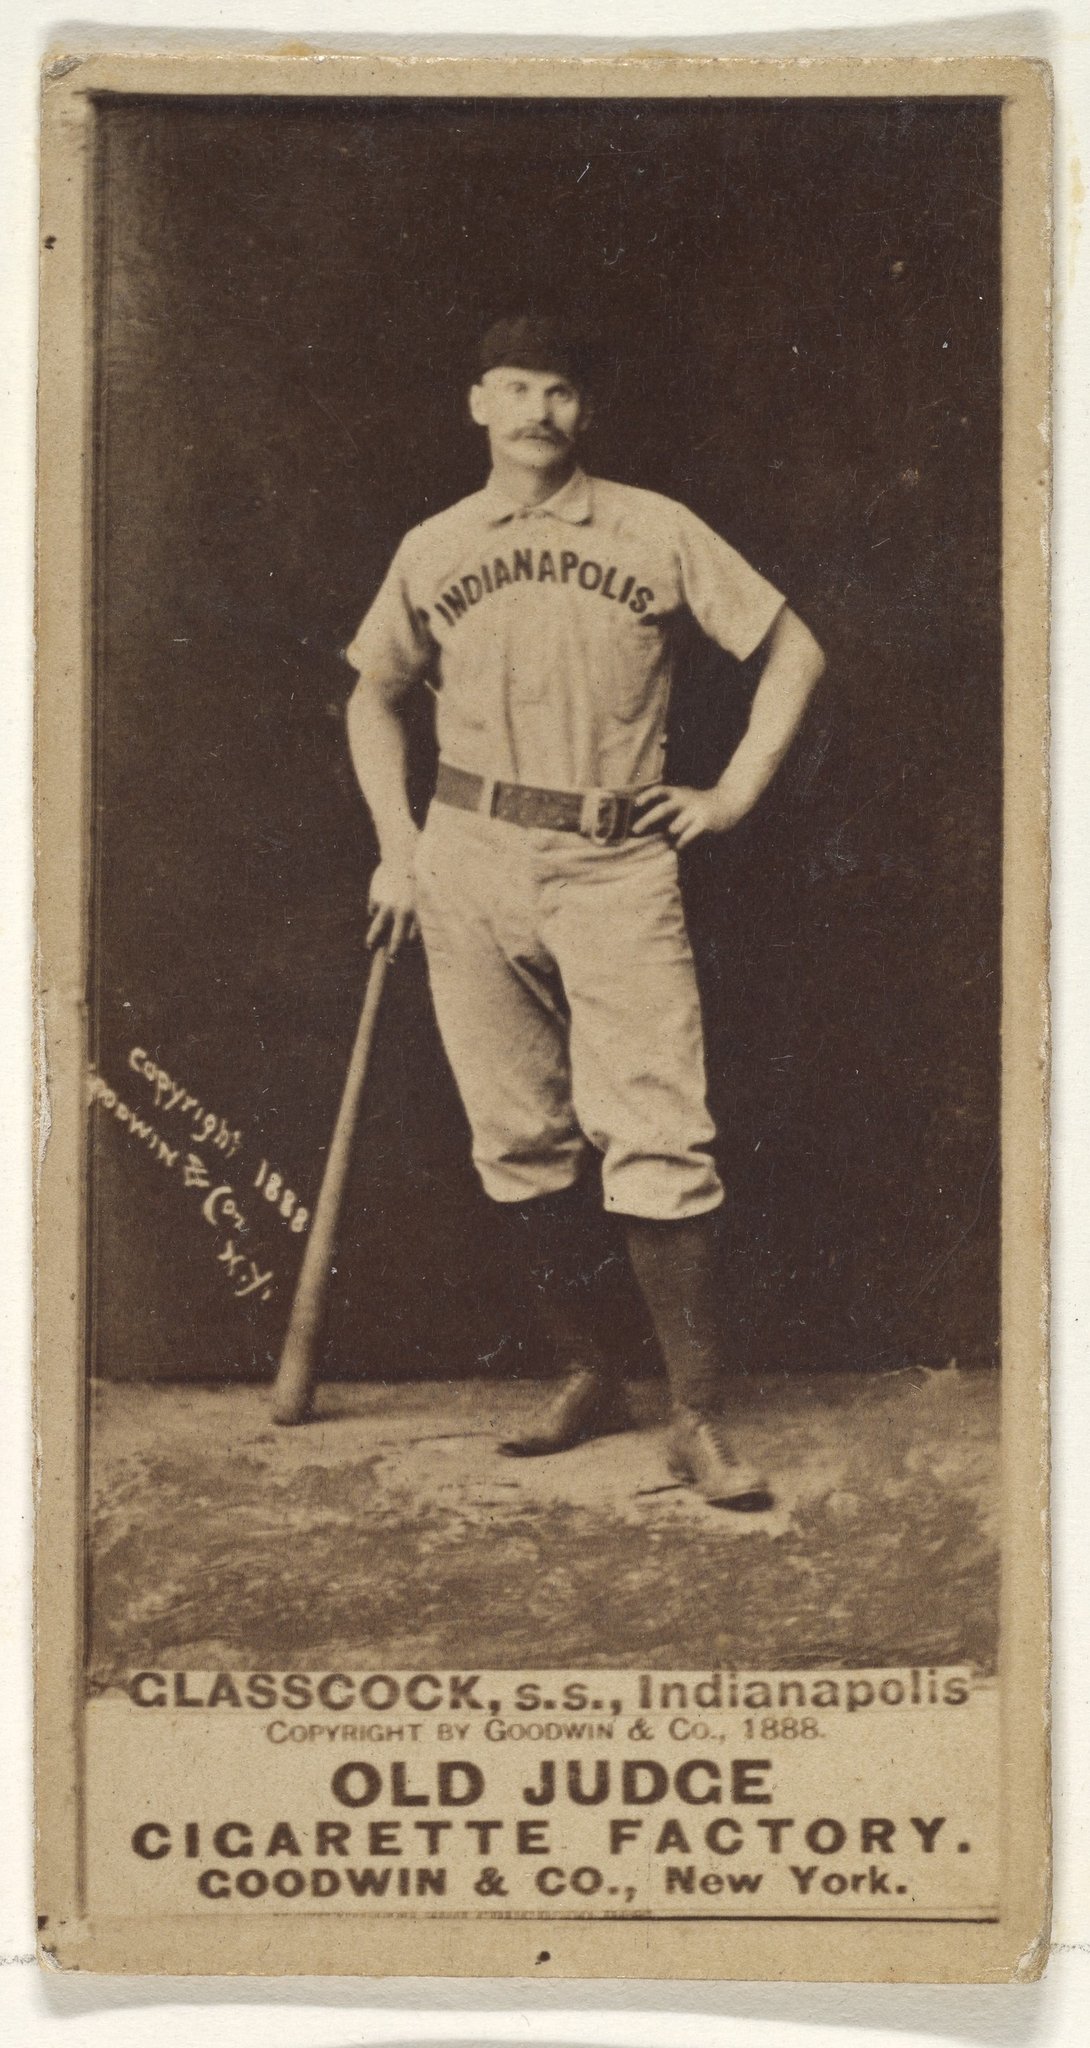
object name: baseball card, photograph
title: Glasscock, Shortstop, Indianapolis, from the Old Judge series (N172) for Old Judge Cigarettes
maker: goodwin & company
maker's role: publisher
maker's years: 1850-1950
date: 1888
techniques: albumen silver print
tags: men,portraits,baseball,athletes